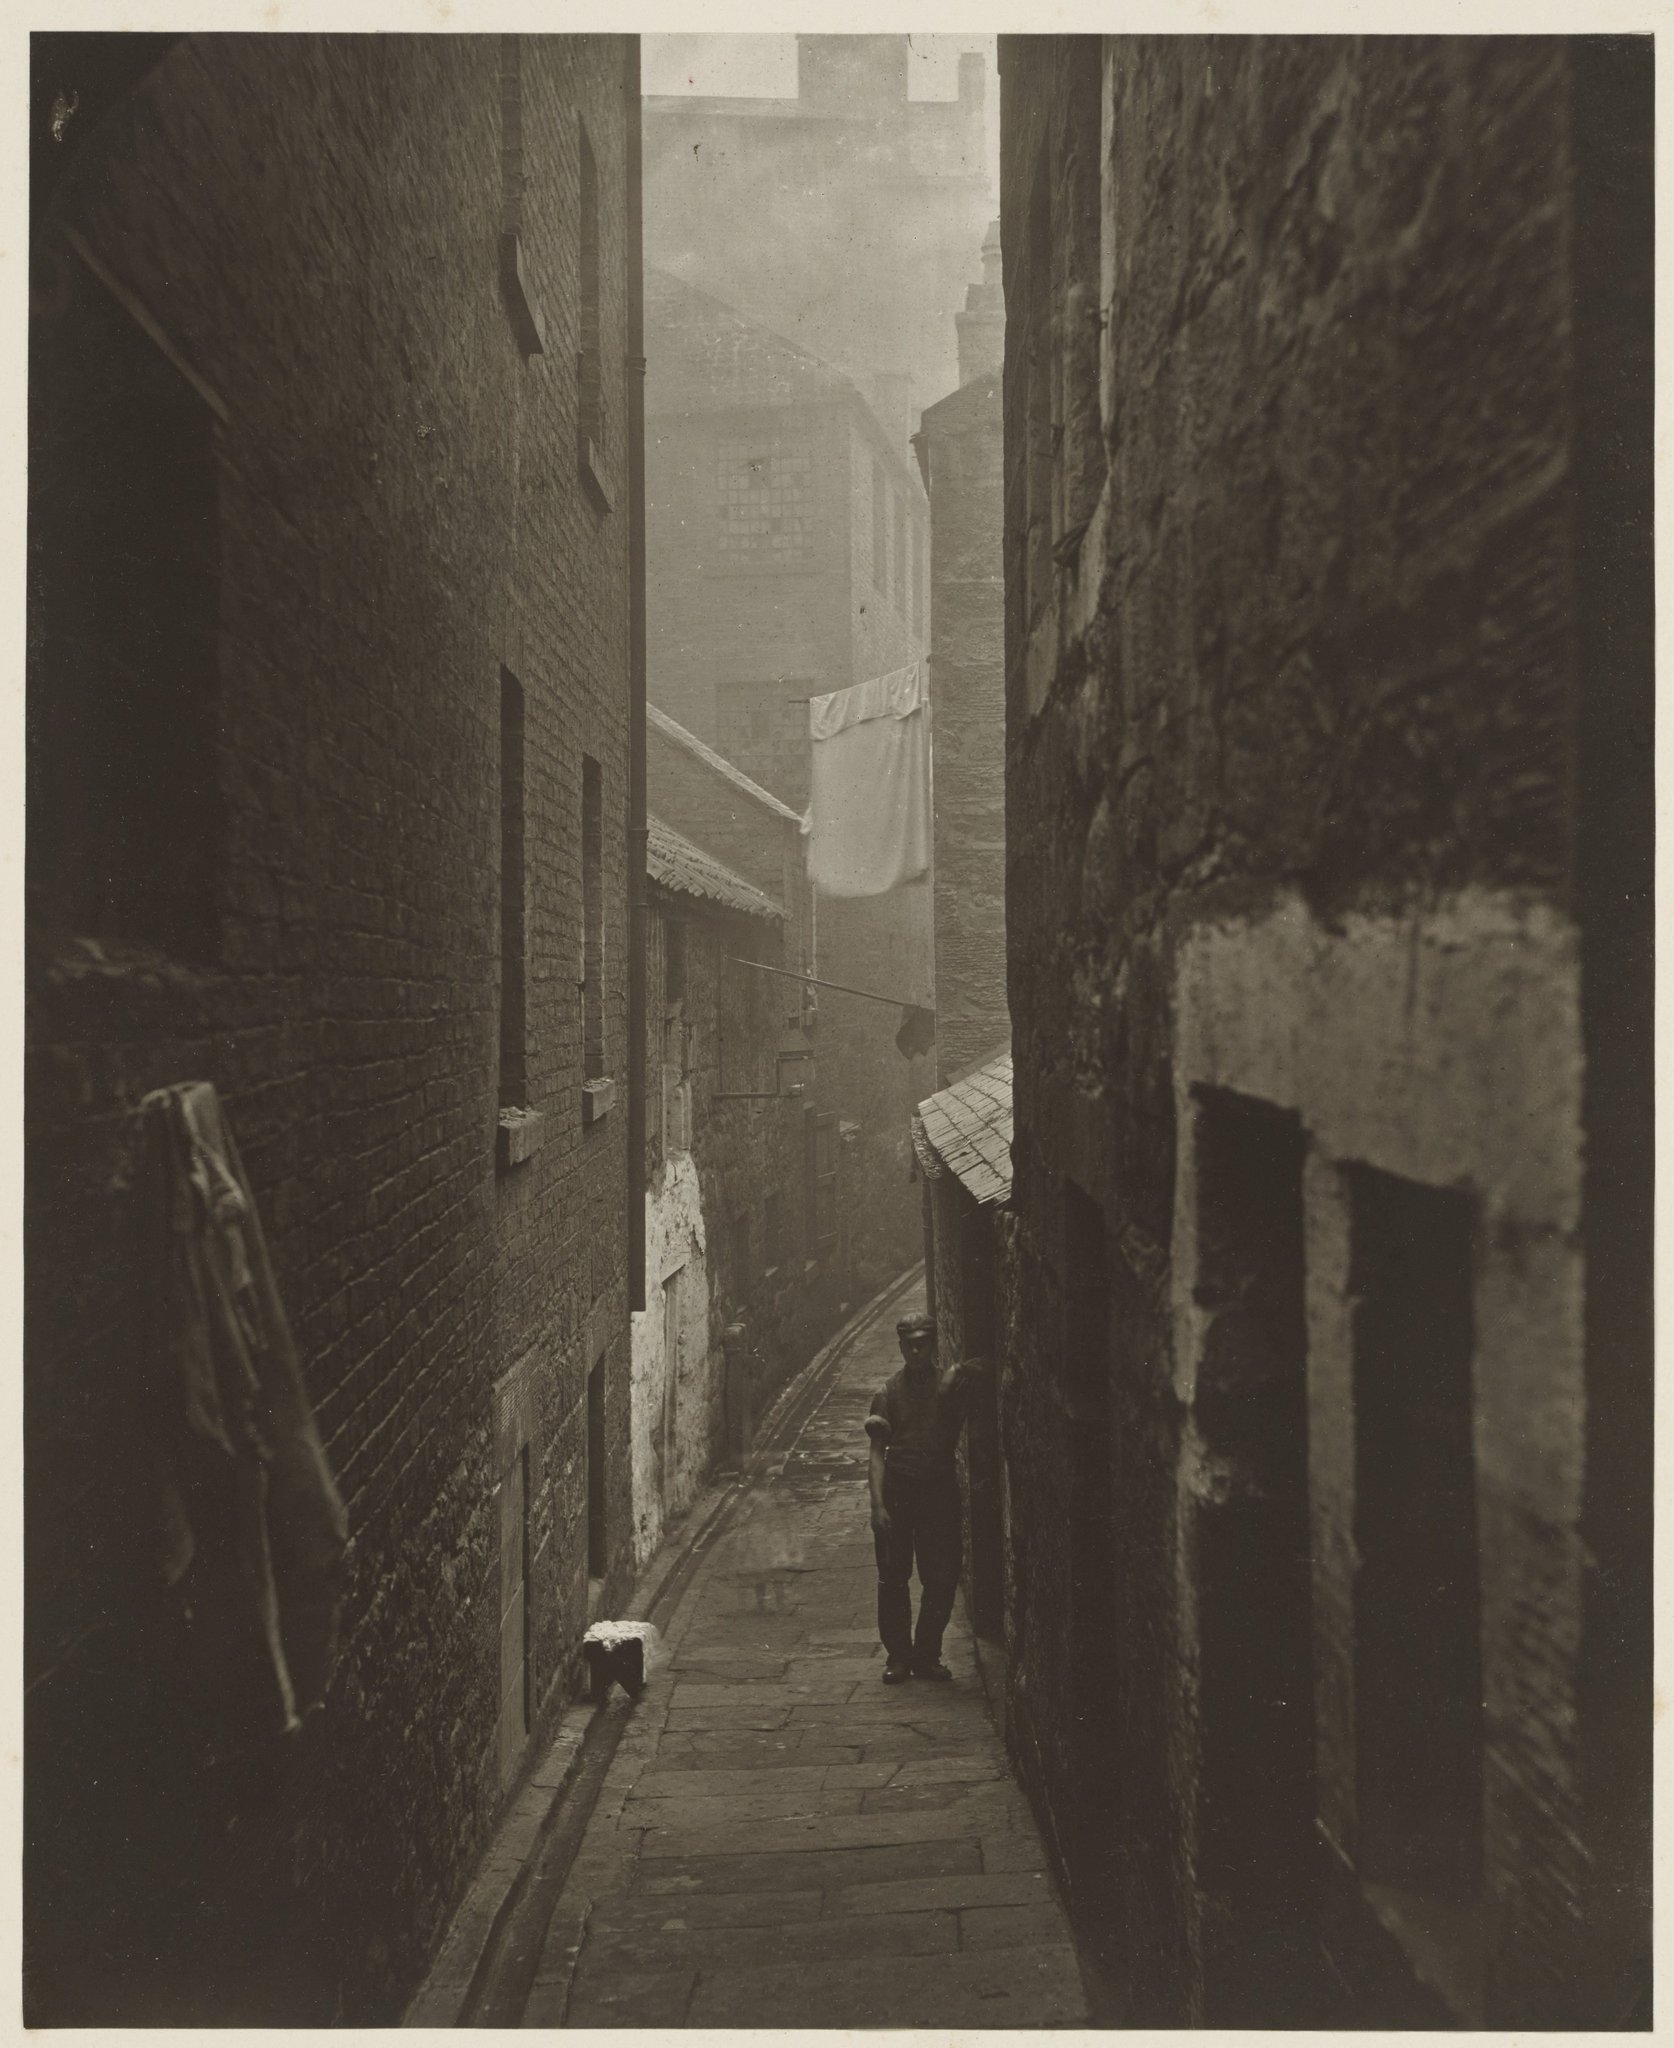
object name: photograph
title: The Slums of Glasgow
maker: thomas annan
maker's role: fotograaf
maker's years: 1829-1887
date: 1868-1877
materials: cardboard, photographic support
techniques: carbon print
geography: glasgow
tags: adult man, lane, alley, glasgow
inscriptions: number: ‘27.’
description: In the series Photographs of Old Closes, Streets, & c., Taken 1868-1877 Annan recorded the slums of Glasgow in 40 pictures just before they were razed to make way for new, clean, and better housing for labourers in the Scottish manufacturing city.